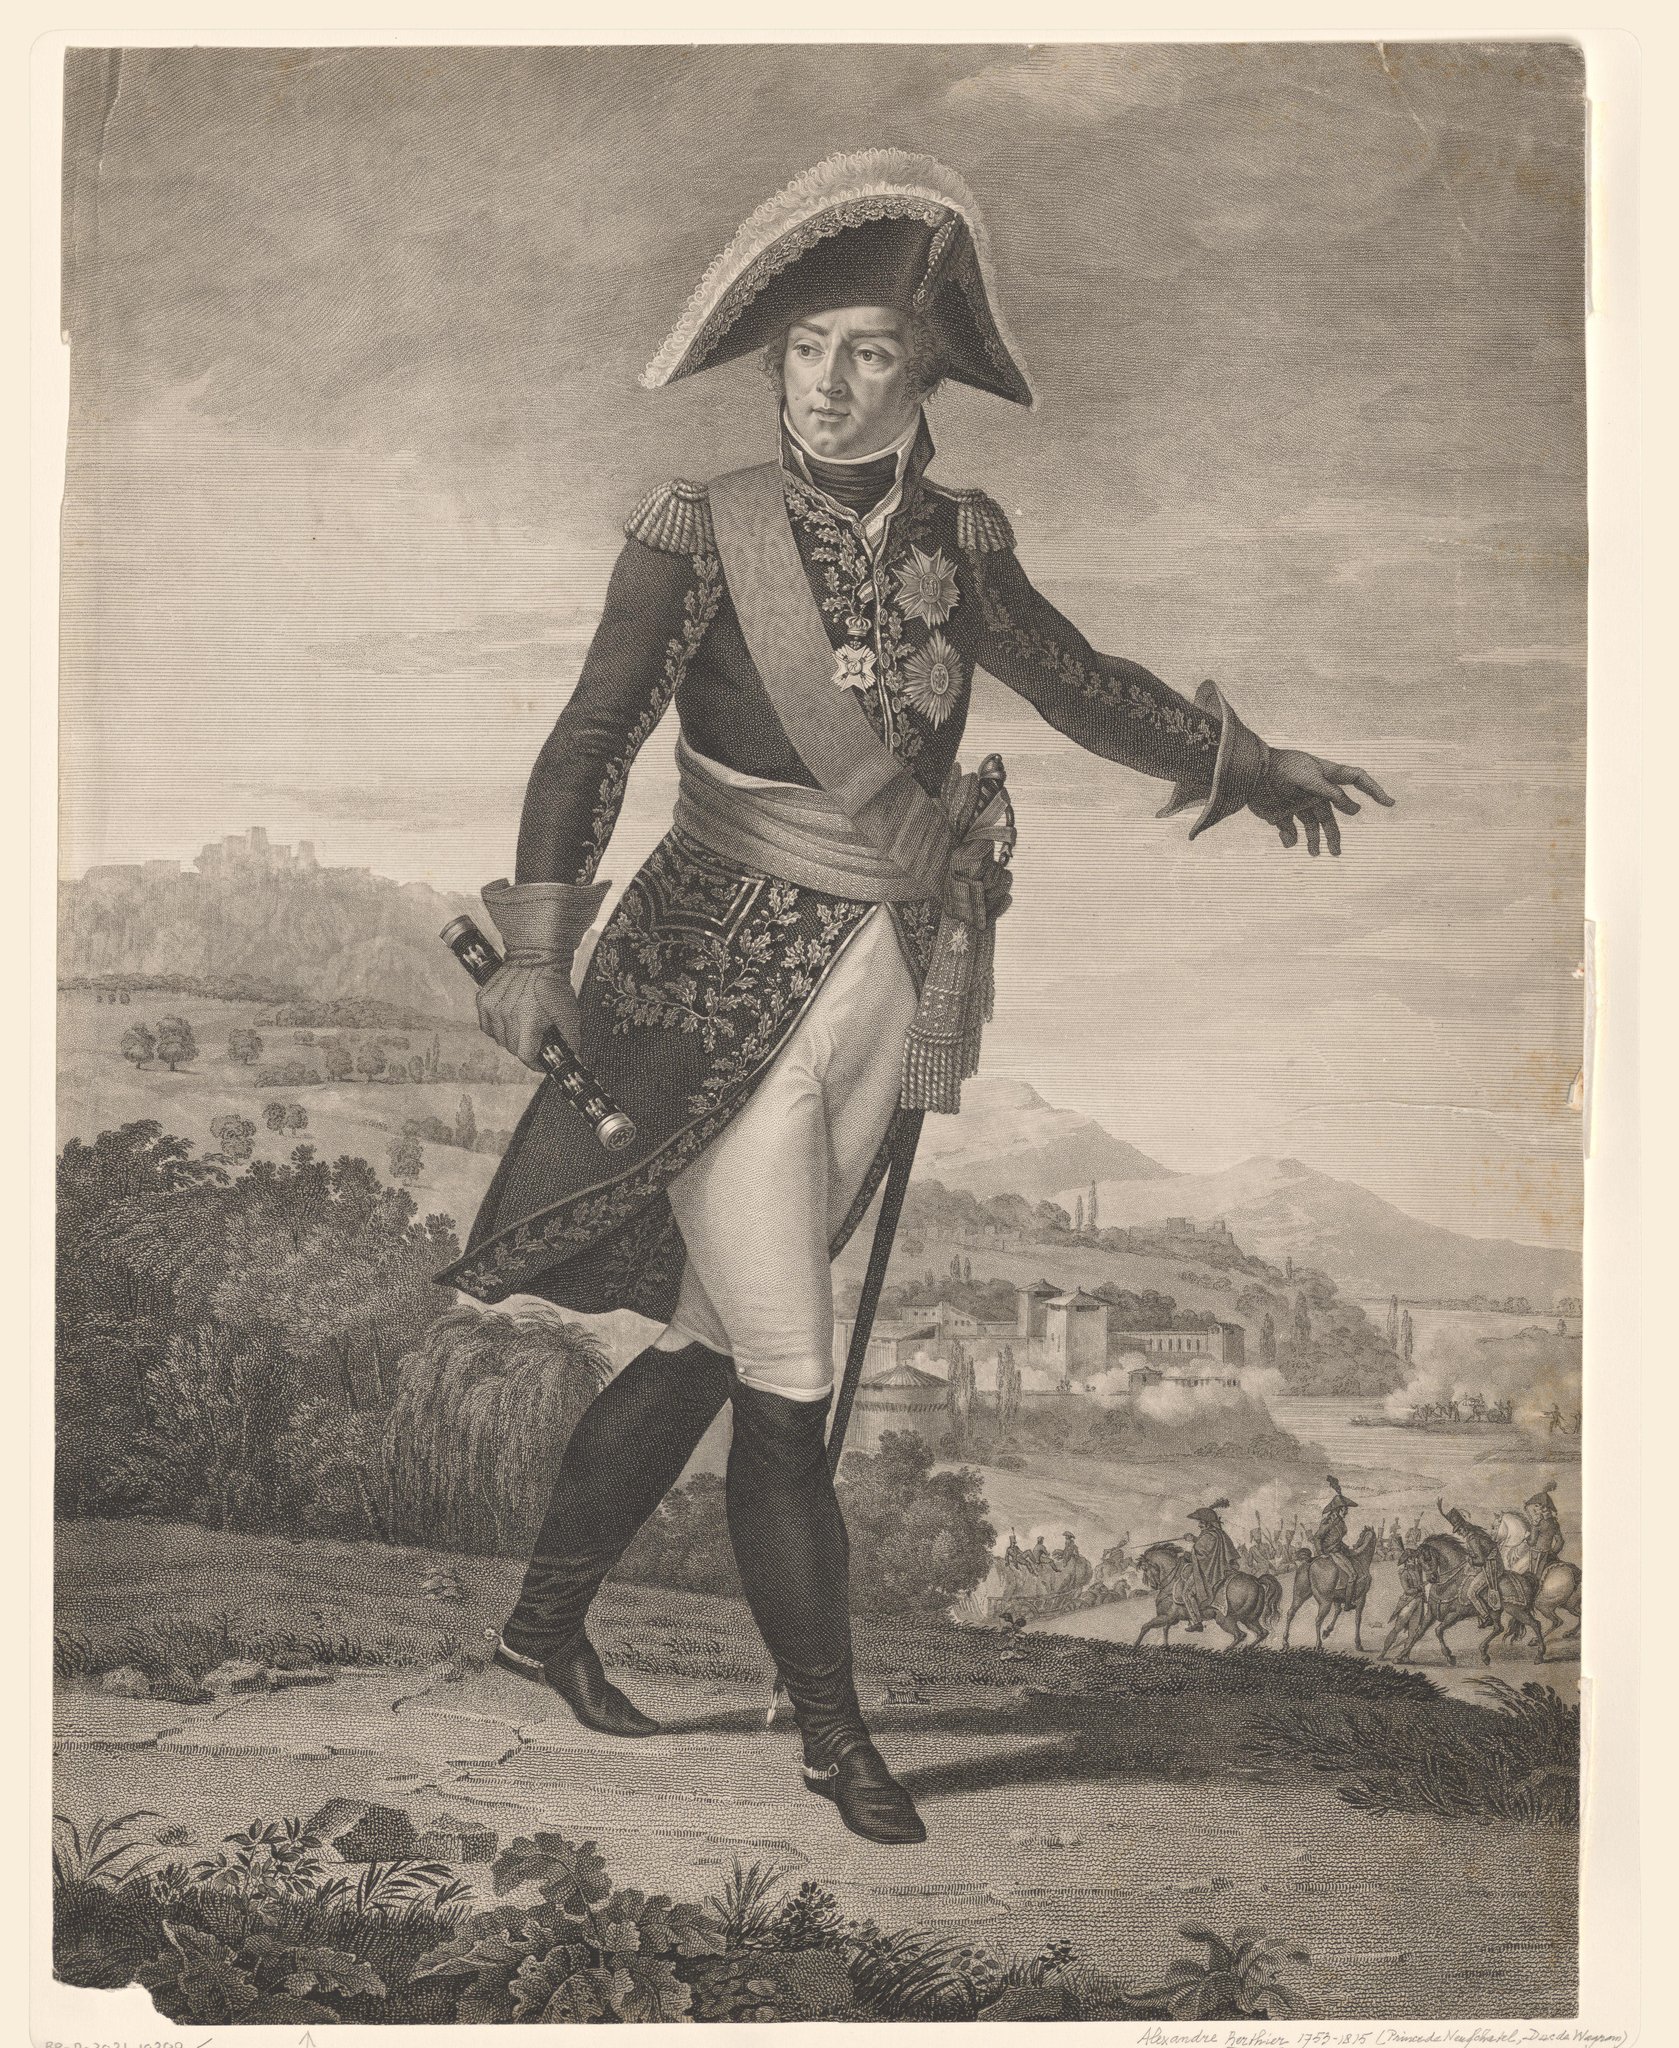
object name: print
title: Portret van Louis-Alexandre Berthier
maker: Anonymous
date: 1795-1850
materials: paper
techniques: etching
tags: city-view, and landscape with man-made constructions, commander-in-chief, general, marshal, historical persons, battle, baton of general